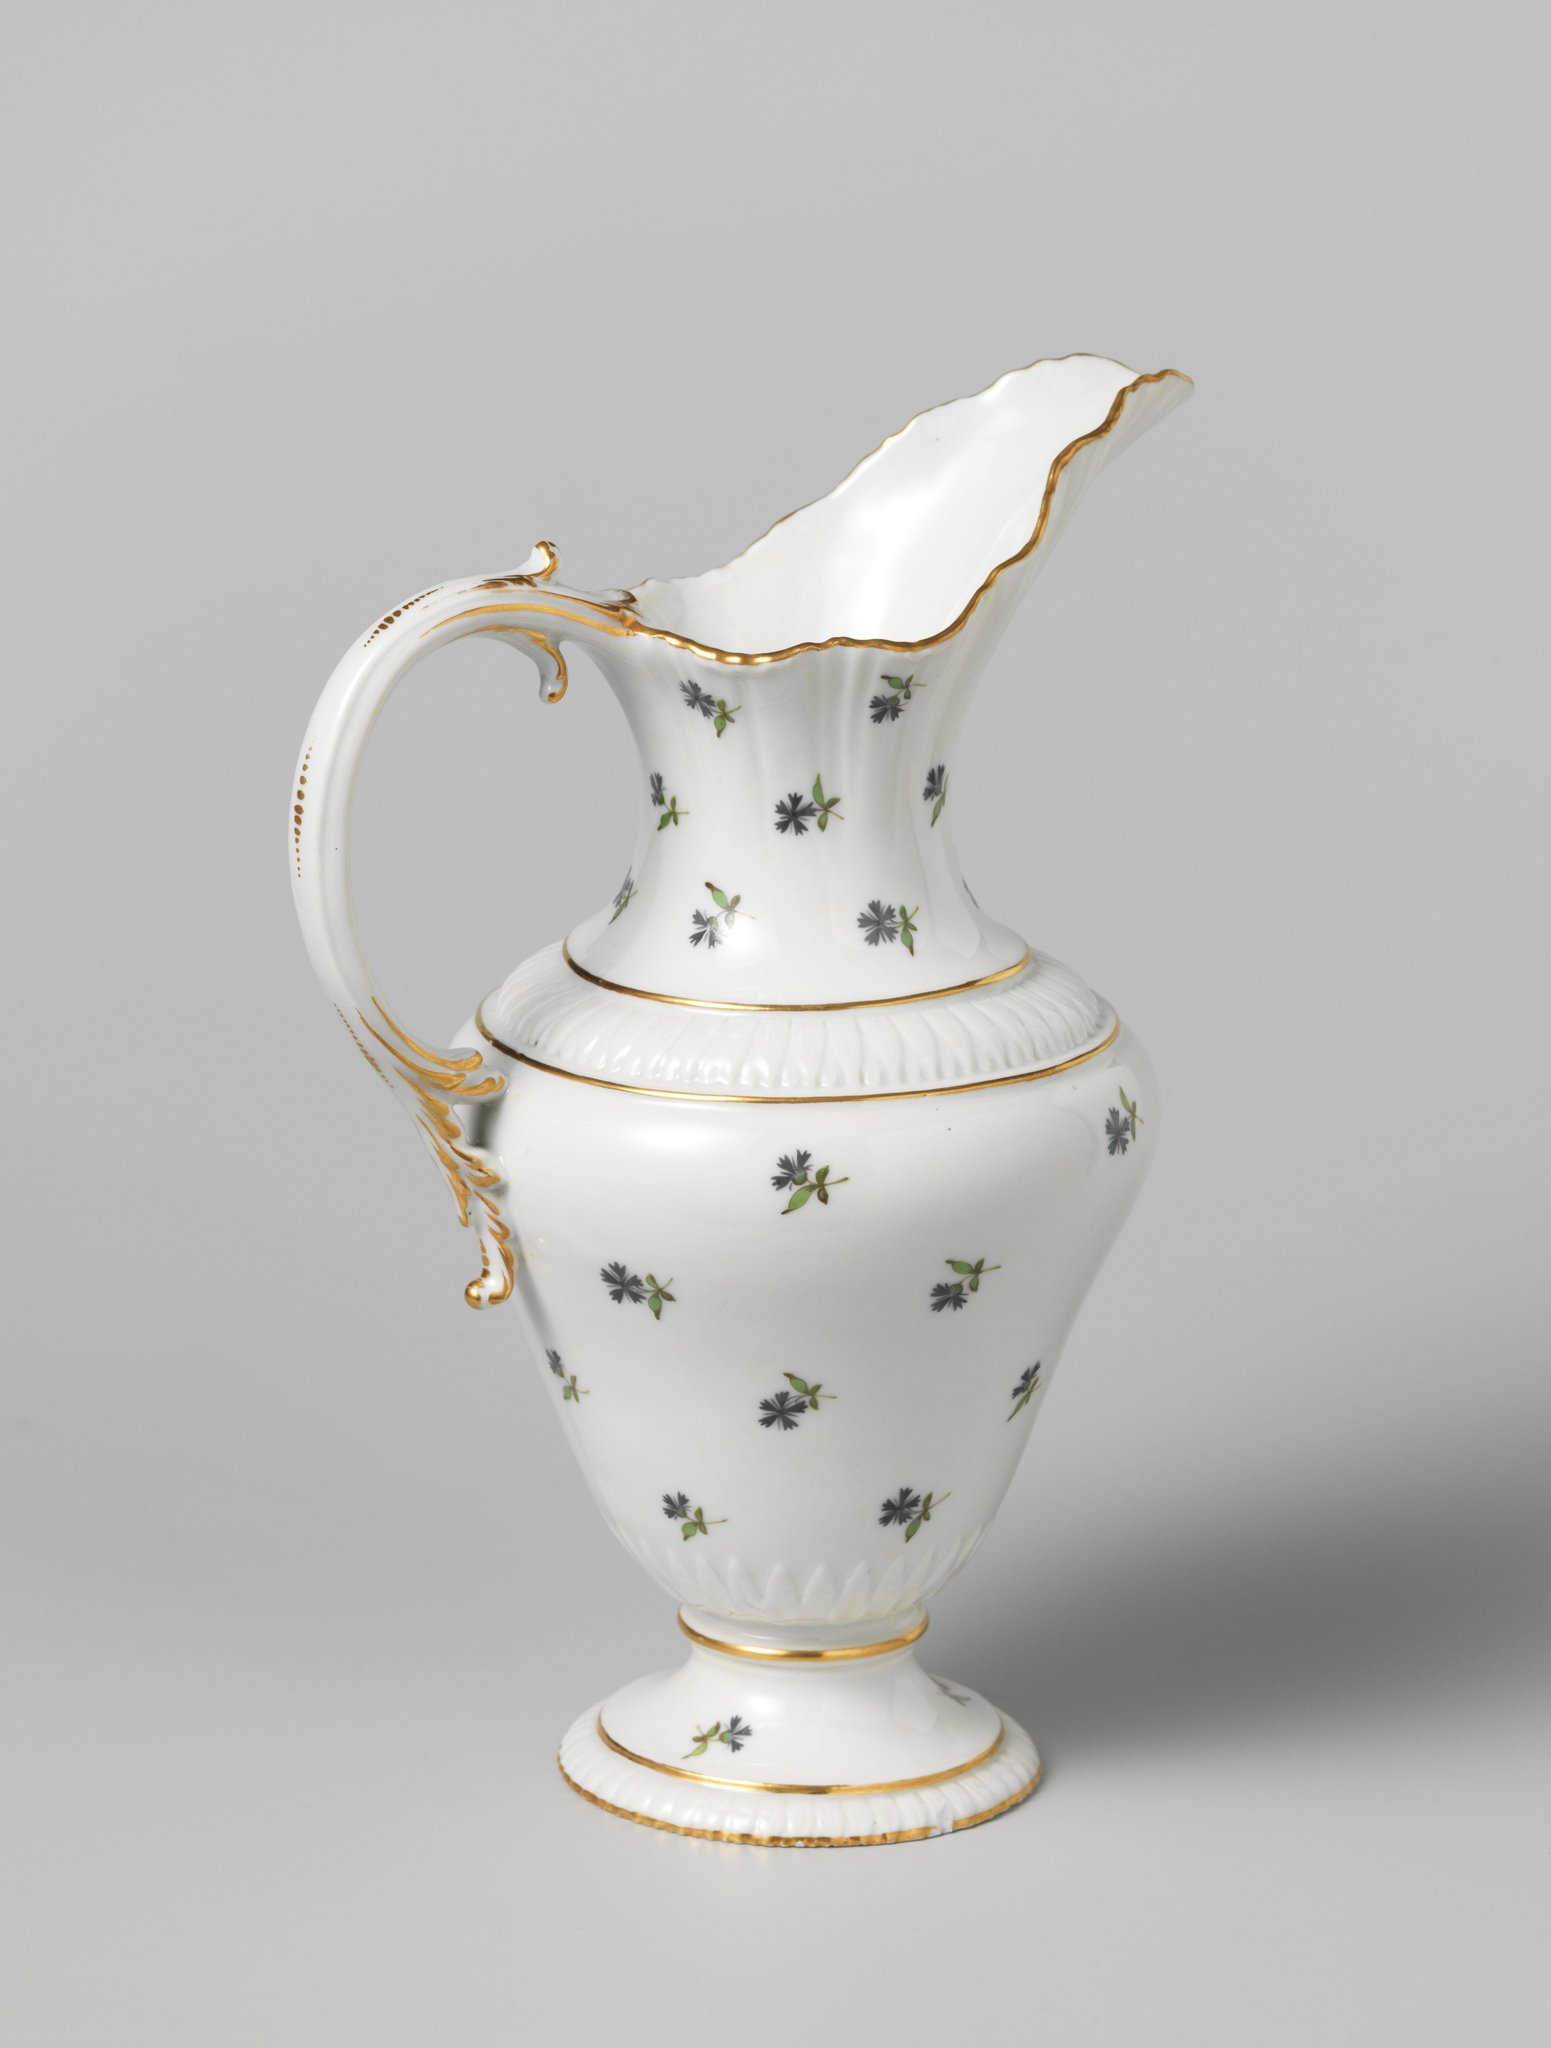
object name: flagon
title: Kan van porselein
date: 1784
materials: porcelain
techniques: painted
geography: loosdrecht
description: Kan beschilderd met een strooipatroon van blauwe korenbloemen en langs de randen gouden biezen. Gemerkt: M.O.L. en Amstel in blauw onder glazuur. De kan met omgekeerd kegelvormige buik, brede uitstekende tuit met gegolfde rand en rocaillevormig oor heeft langs de voet en hals reliëf-bladranken en is langs alle randen met goud afgezet.